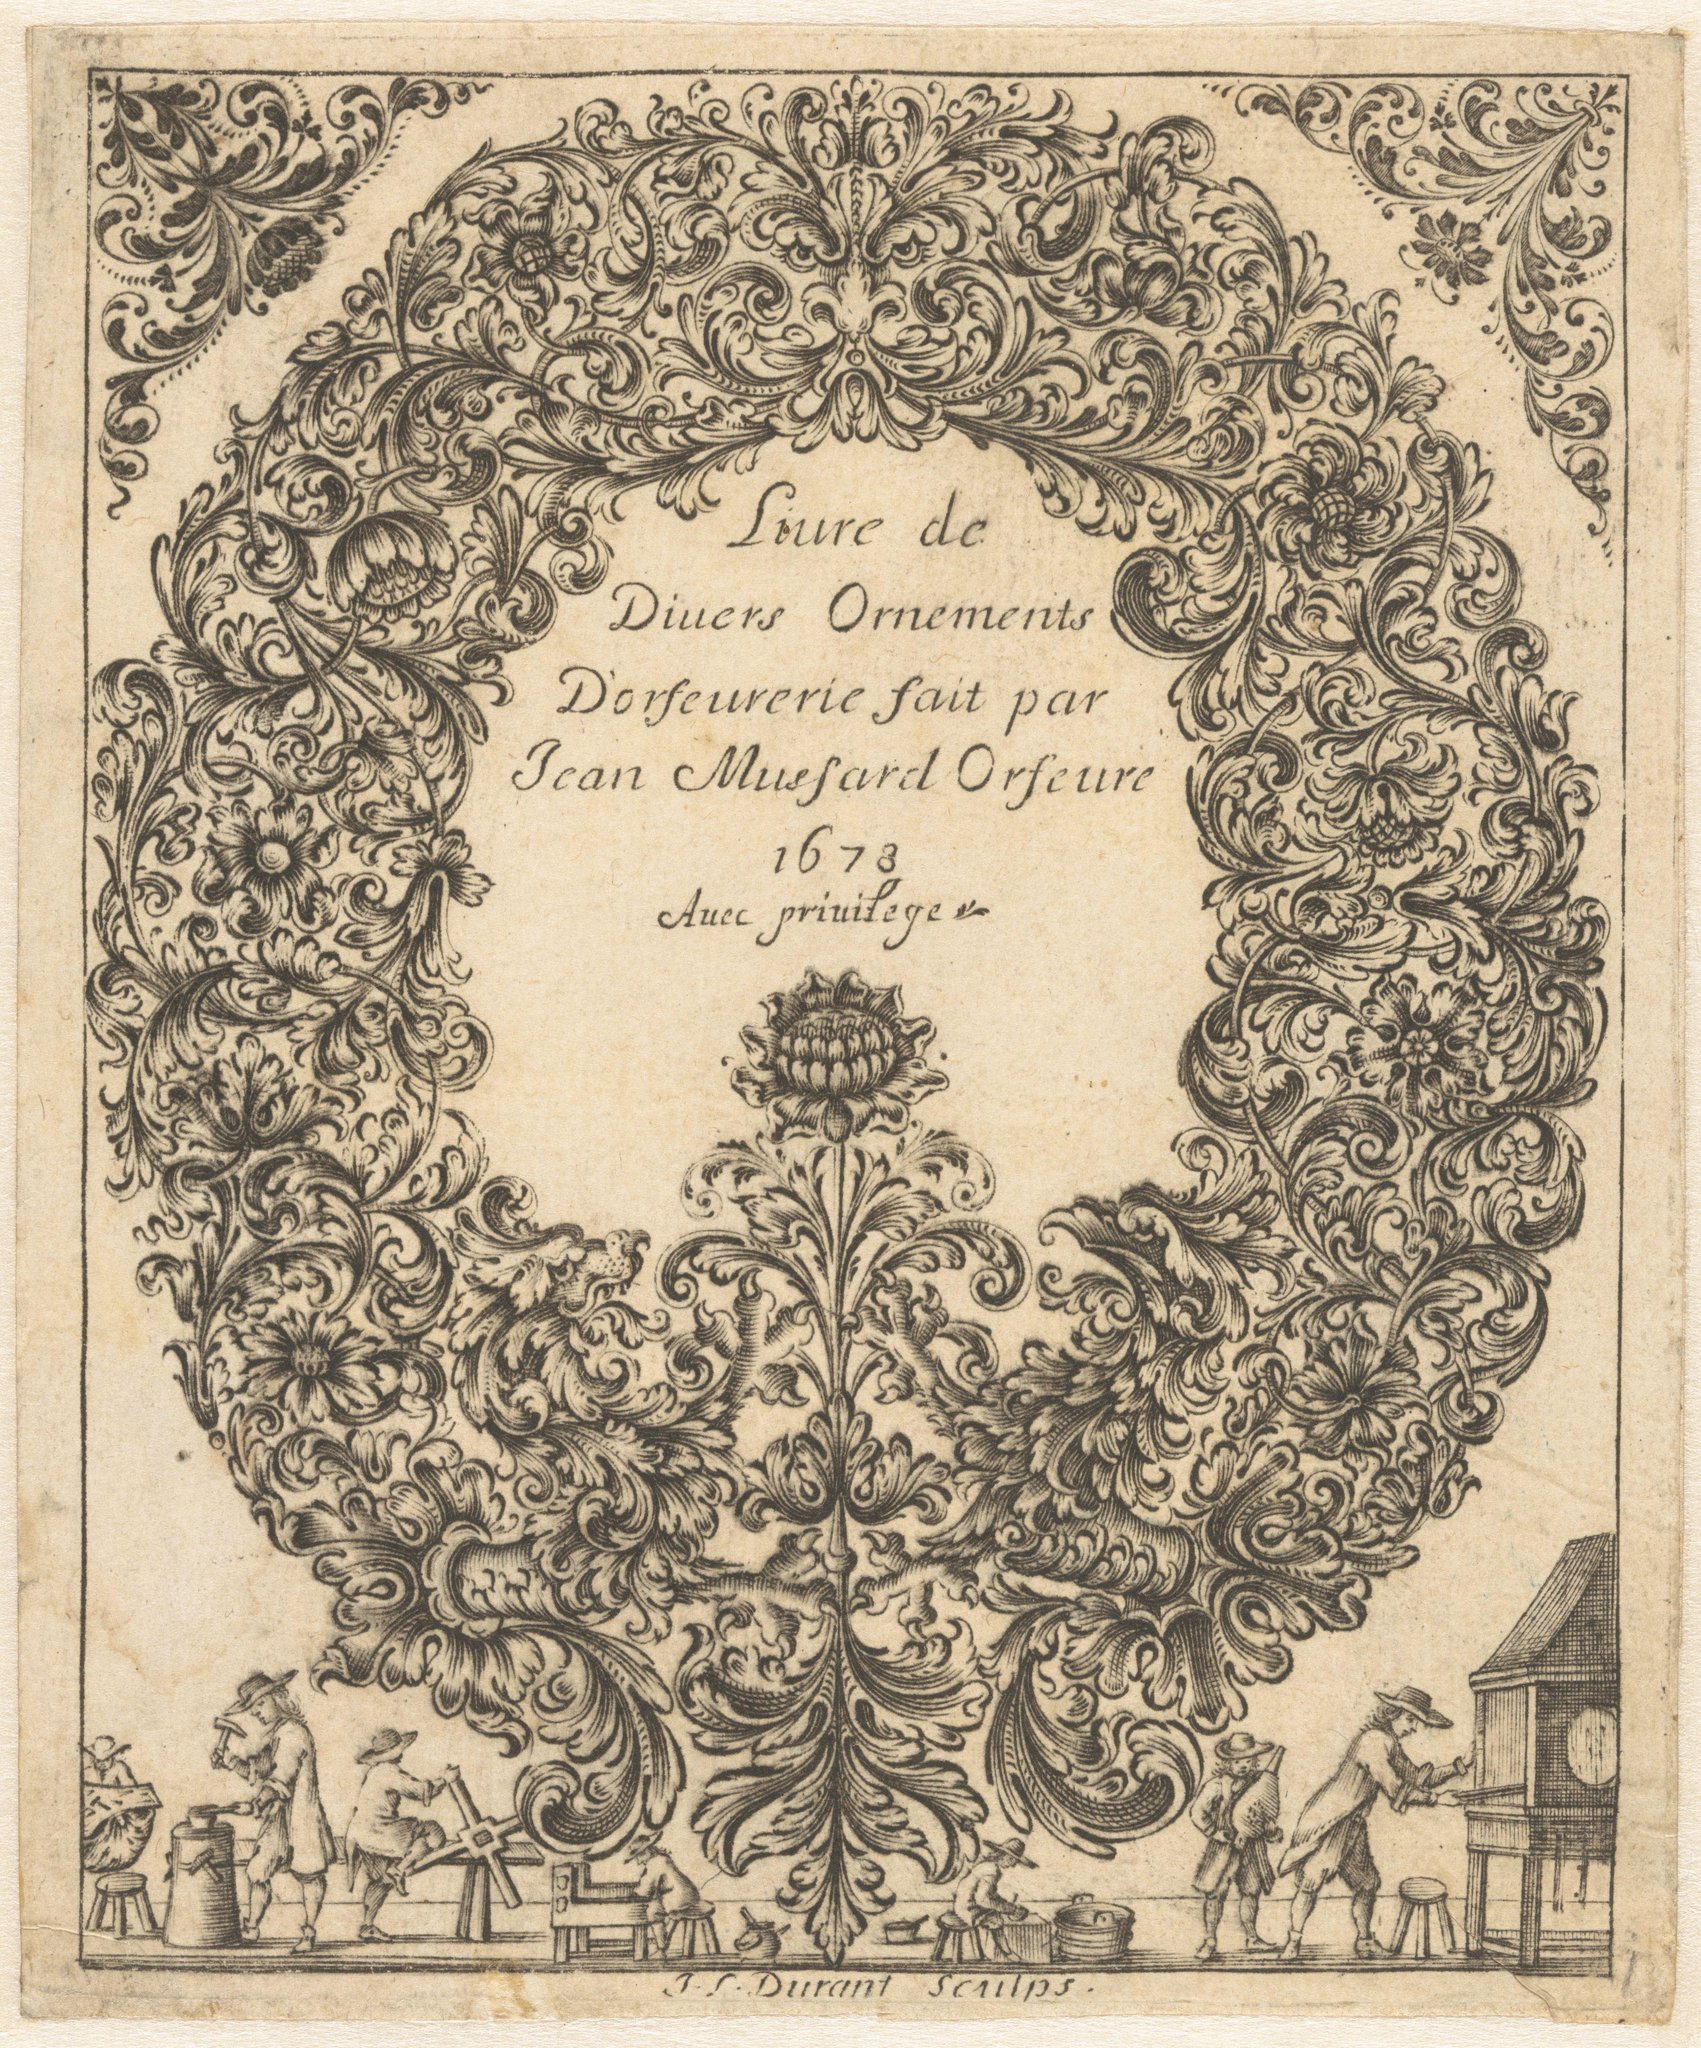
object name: ornament print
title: Titelprent: Livre de Divers Ornements D'orfevrerie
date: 1673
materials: paper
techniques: engraving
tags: ornaments ~ art, foliage ~ ornament, title-page, jeweller, goldsmith, silversmith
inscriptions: signature: ‘J.L. Durant sculps.’, date: ‘1673’, collector's mark: Lugt 2228, signature: ‘fait par Jean Mussard Orfevre’, collector's mark: Lugt 2760, privilege: ‘avec privilege’, collector's mark: Lugt 190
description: Titelprent van een serie van zes bestaande uit een krans van gebladerde ranken met een bloem met daarboven de tekst. Onderaan zijn voorstellingen van edelsmeden. Links- en rechtsboven in de hoeken zijn nog twee ornamentele versieringen.